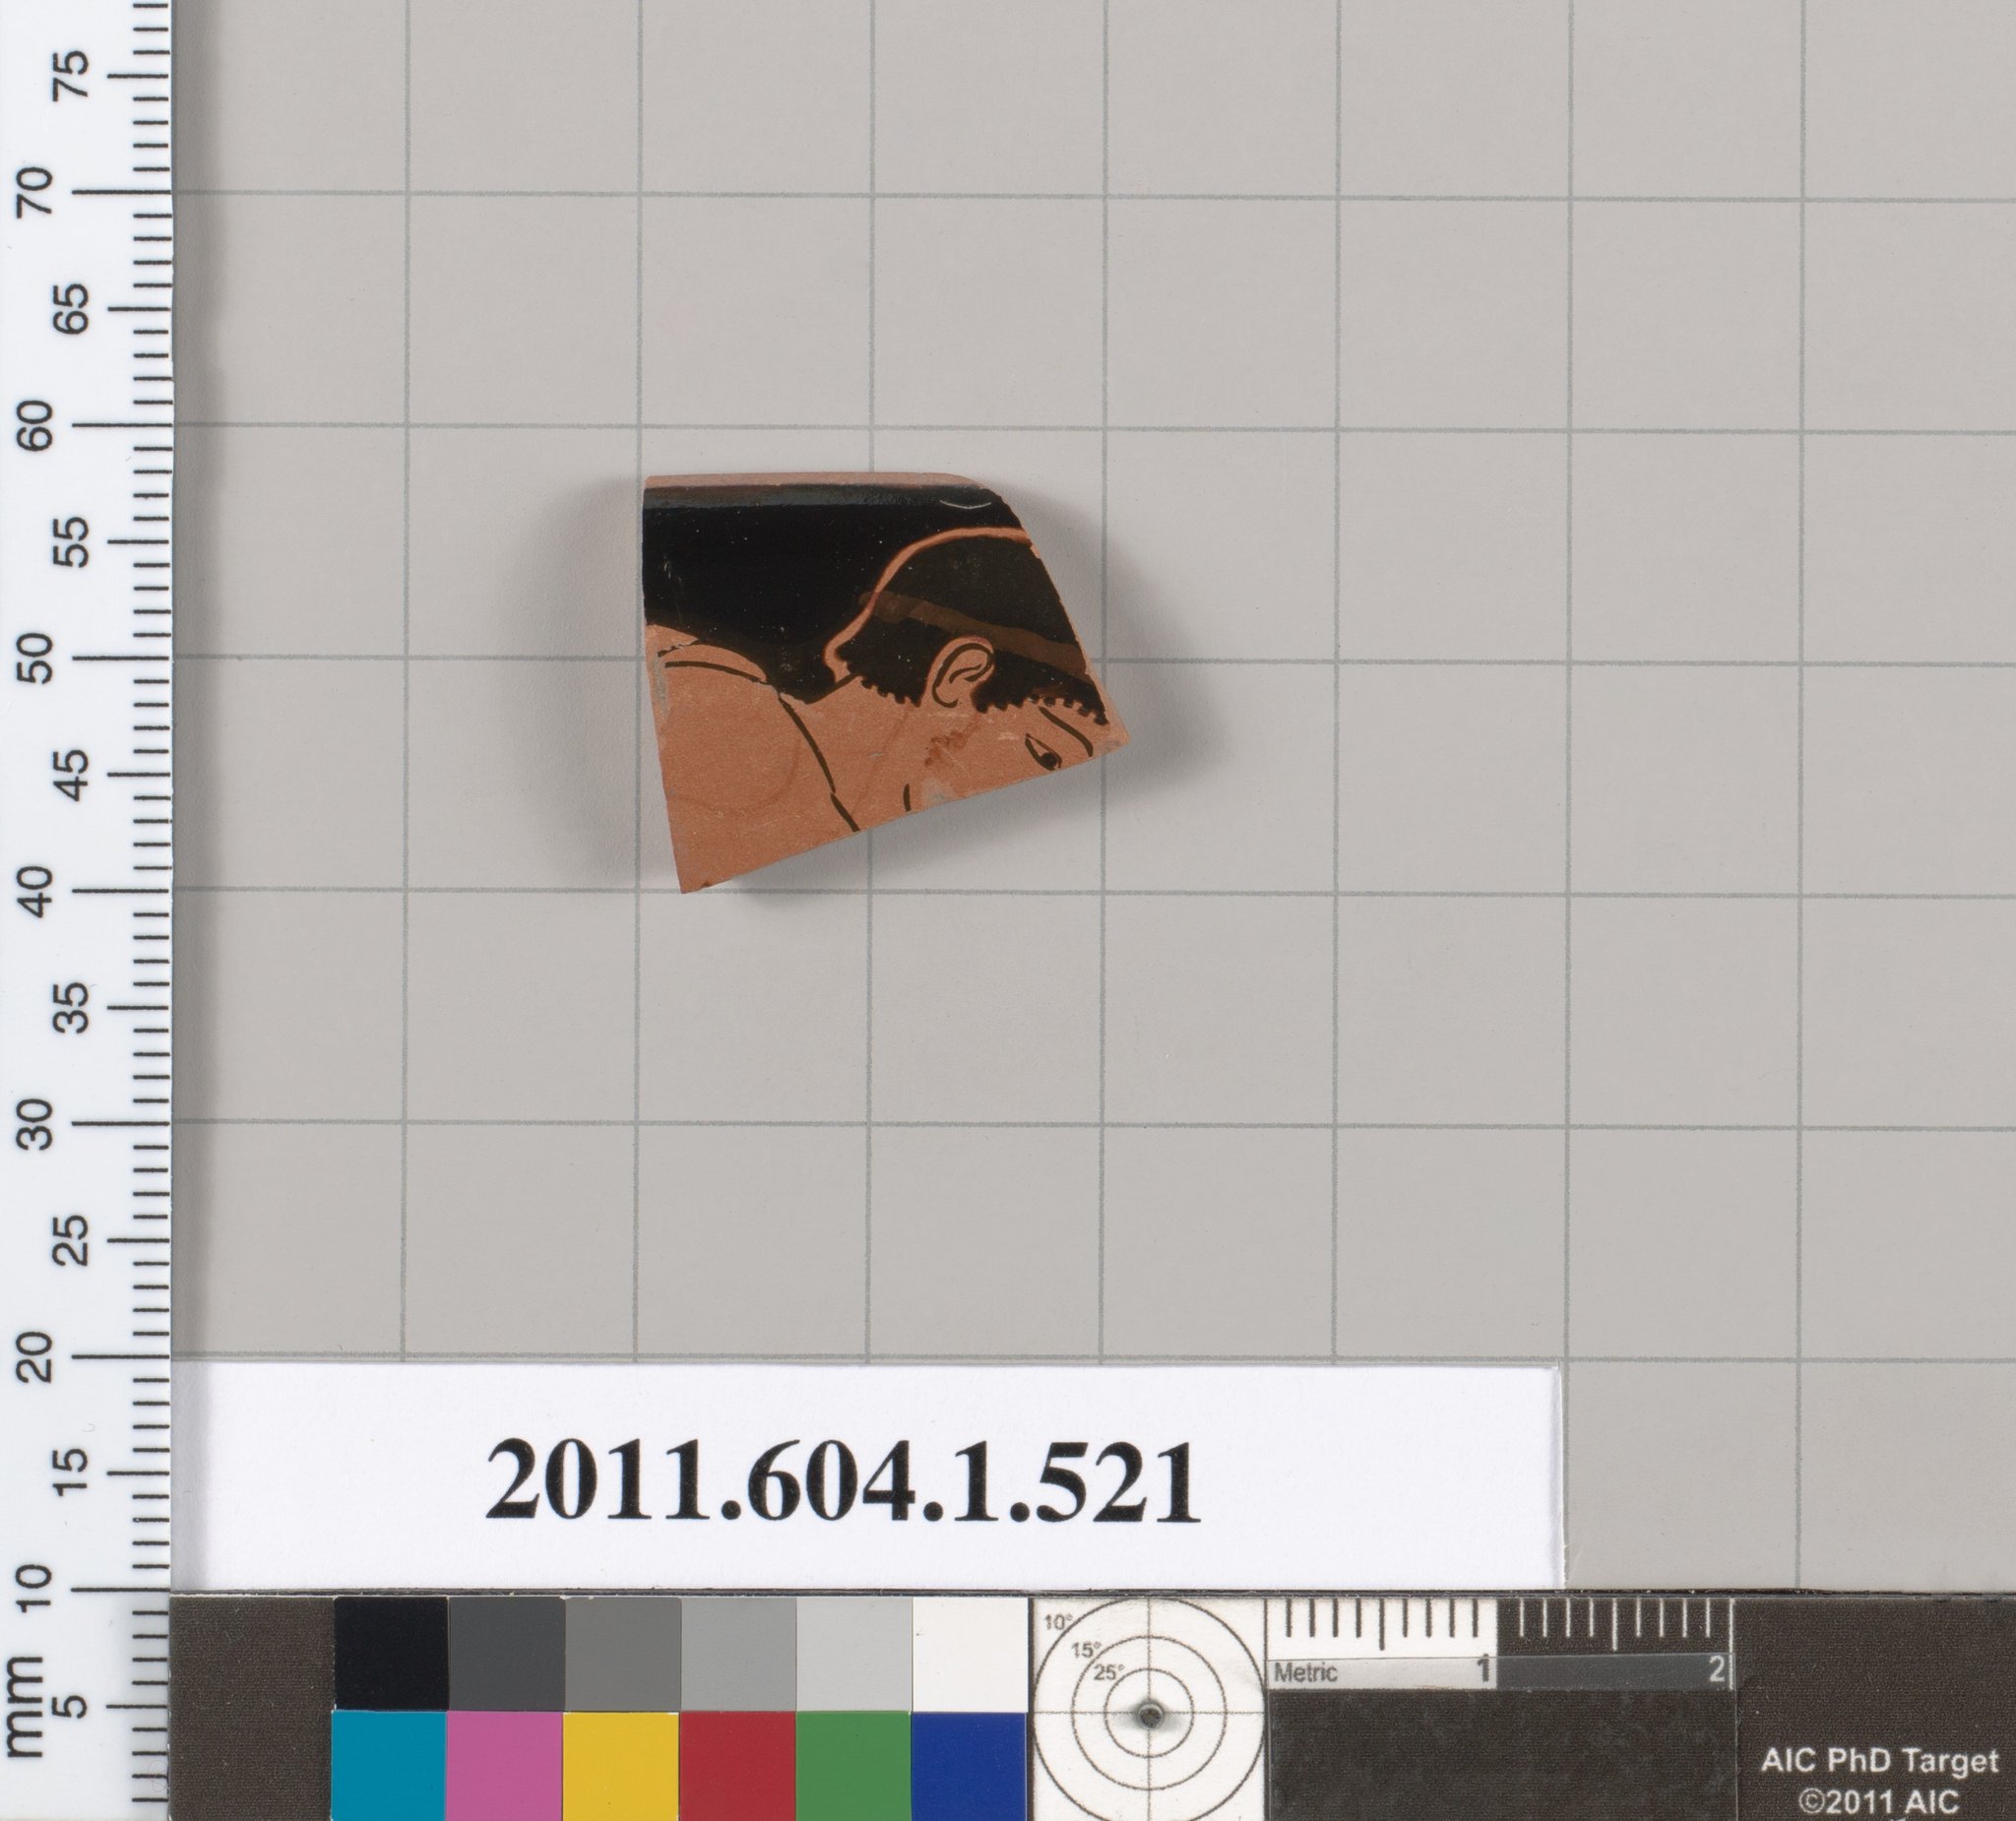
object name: kylix fragment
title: Terracotta rim fragment of a kylix (drinking cup)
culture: greek, attic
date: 490-480 BCE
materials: terracotta